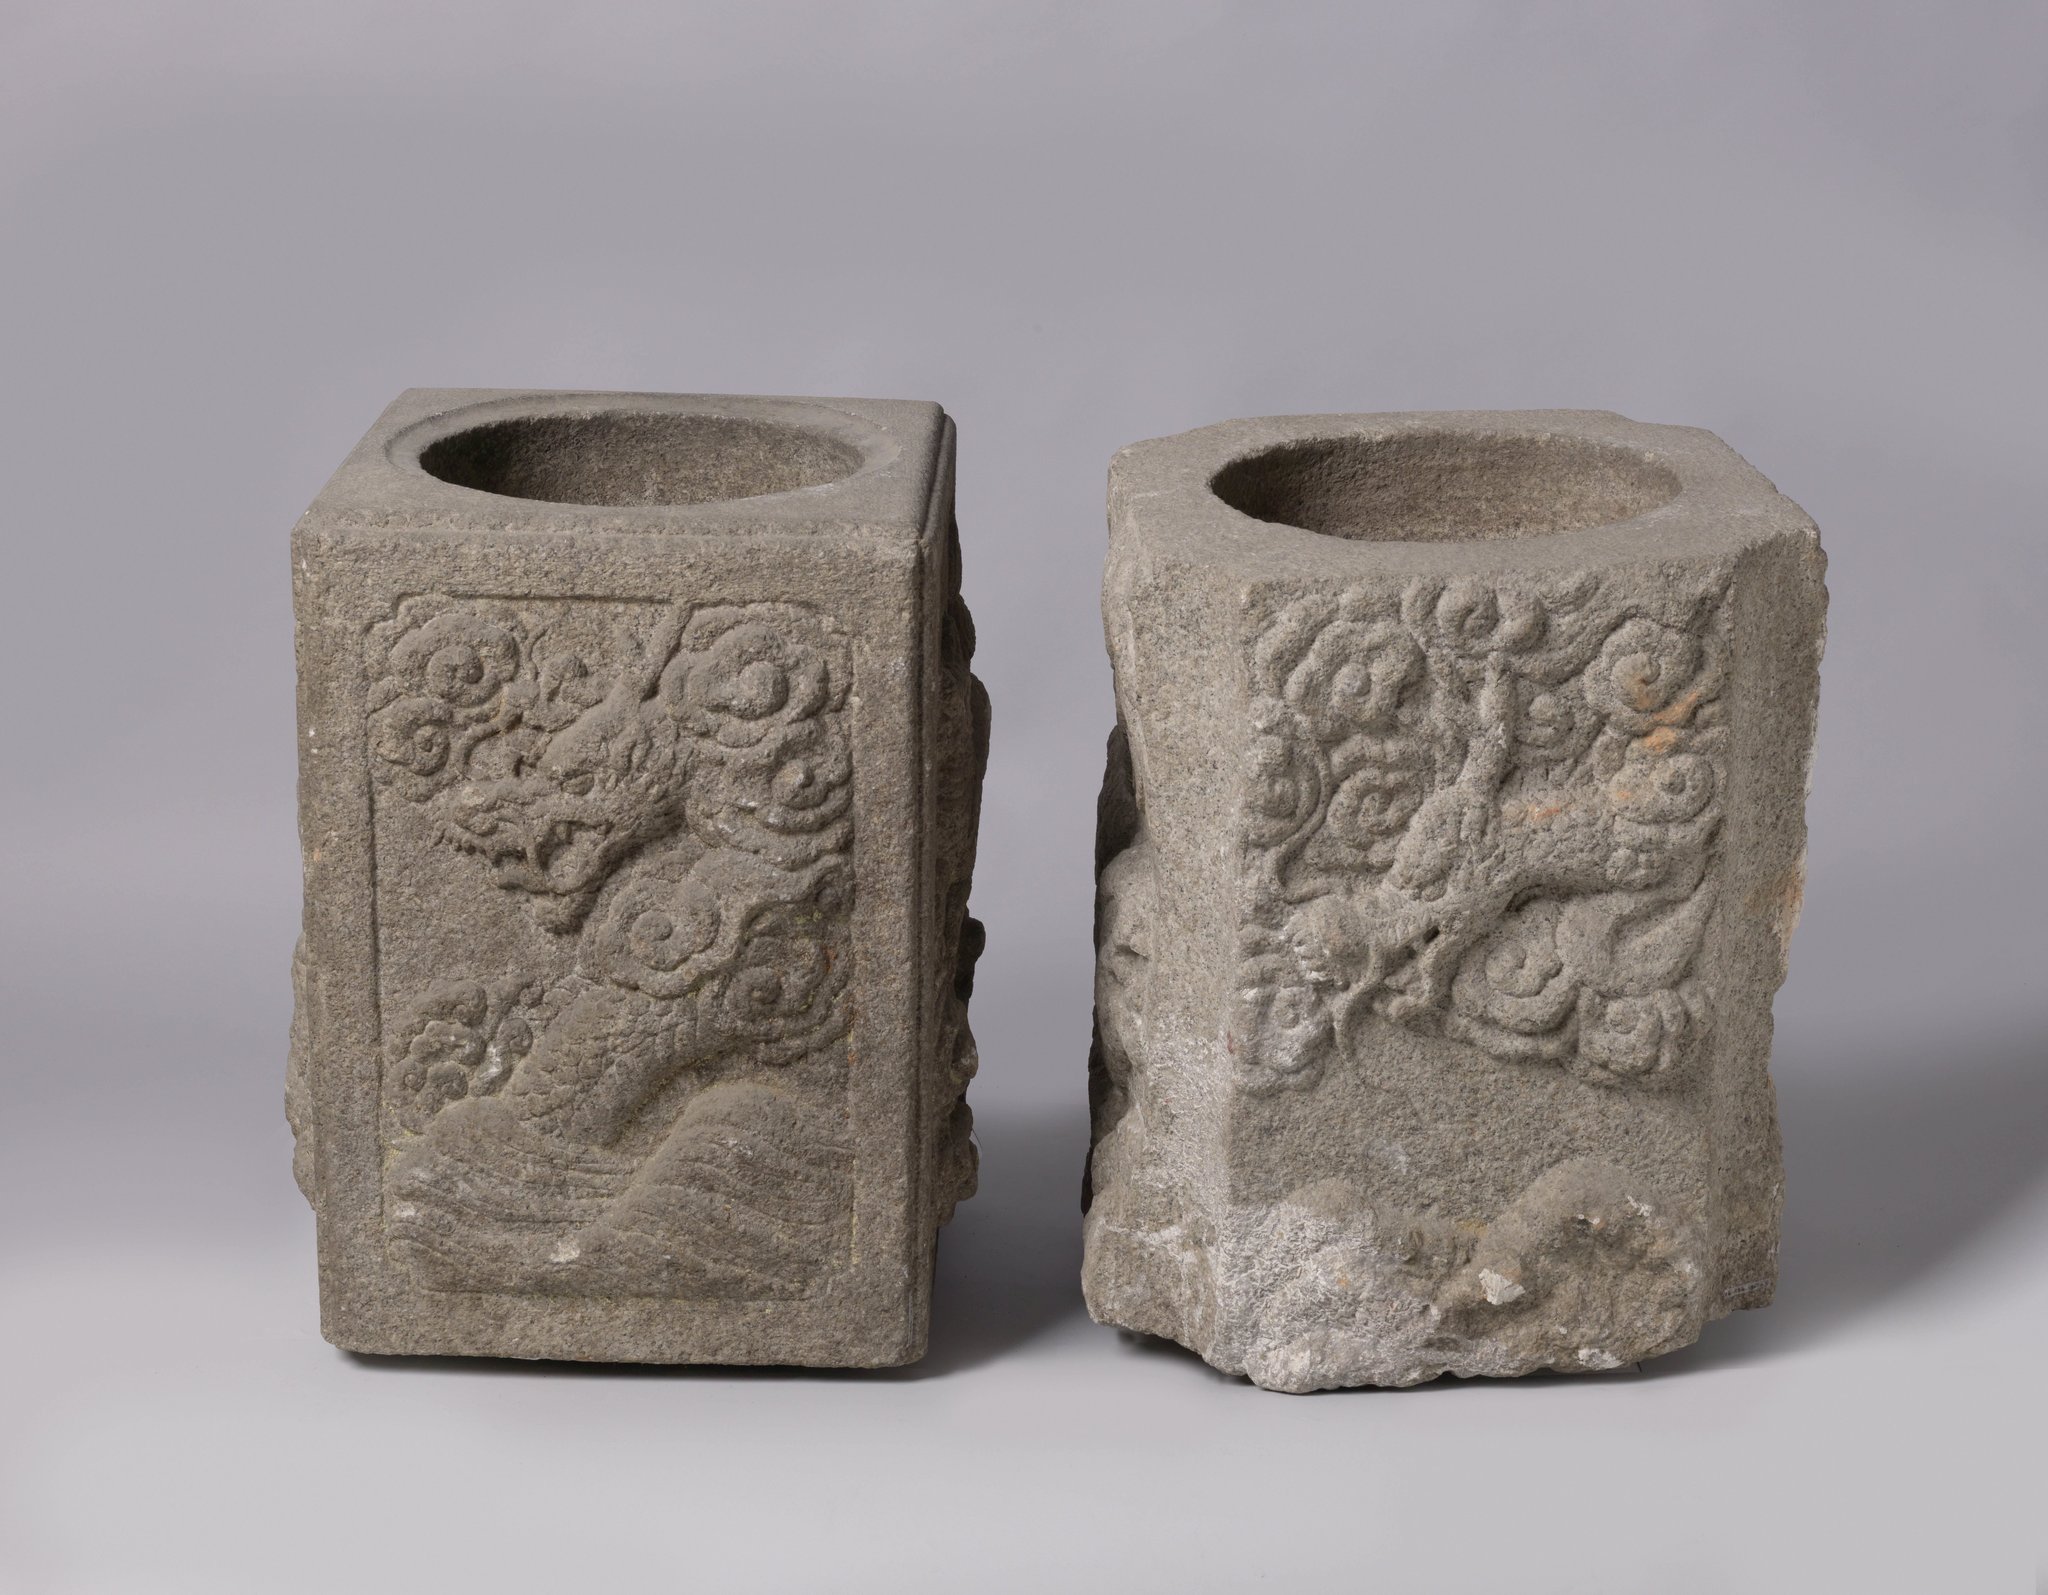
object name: vase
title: Tuinvaas, vierkant met reliëfversiering op de vier zijden van een tijger, een leeuw, een ch'i-lin en een draak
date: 1700-1800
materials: granite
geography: china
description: Tuinvaas, deel van een paar, vierkant. Massief, slechts aan de bovenzijde bolvormig uitgehold. De vaas vertoont op de vier rechthoekige zijden een paneel-verxiering in reliëf, bestaande uit een tijger, een leeuw, een ch'i-lin (Chinees fabeldier) en een draak. De verzamelaar Erdmann plaatste op de vaas een zinken tuinfontein in de vorm van een putto, welke de schenkster behield. Opmerking: vaas A afwijkend van versiering. Opmerking: afkomstig uit de verzameling mr R.H. Erdman, landgoed Terra Nova te Loenen a/d Vecht. Voorheen afkomstig van de door Reinhard van Scherenberg te Baarn gebouwde landhuizen in Chinese stijl genaamd Peking (1791) en Canton (1793). De bouwmaterialen en tuinversiering waren rechtstreeks uit China geïmporteerd. De villa's werden resp. in 1890-1891 en 1910 afgebroken. Wanneer de vazen in handen van Erdmann zijn gekomen en van welke der twee villa's ze afkomstig zijn, kon niet worden nagegaan.